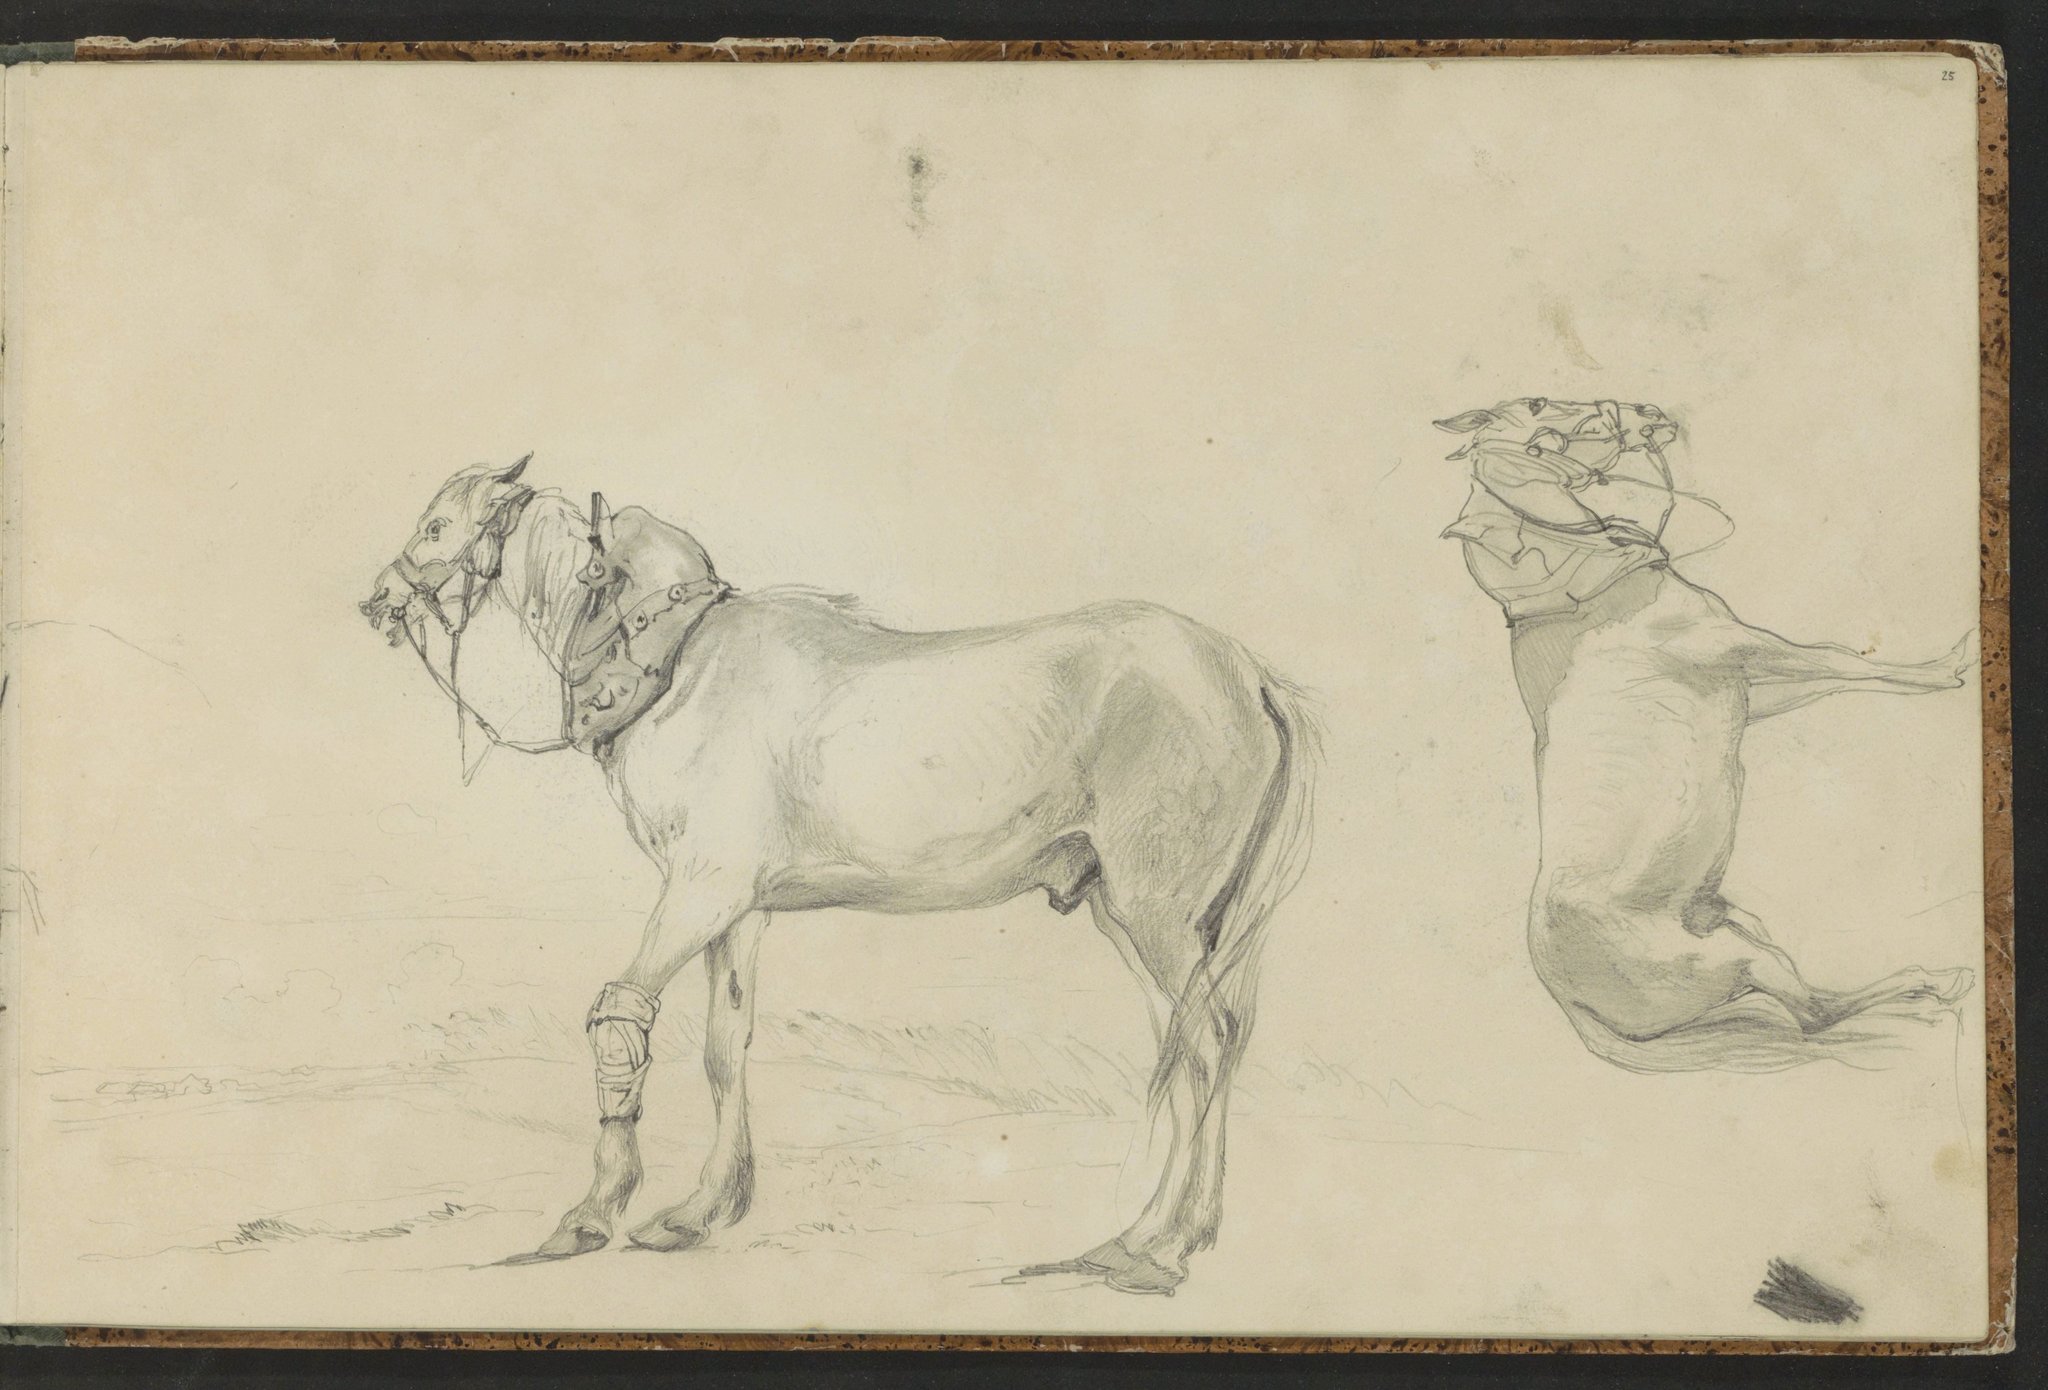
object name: sketchbook leaf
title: Twee paarden met een tuig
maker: johannes tavenraat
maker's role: draughtsman, painter, print maker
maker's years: 1809-1881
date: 1840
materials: paper, pencil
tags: dressing, bandage, head-stall, horse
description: Eén van de paarden heeft een verband om de knie. Blad 25 recto uit een schetsboek met 33 bladen.